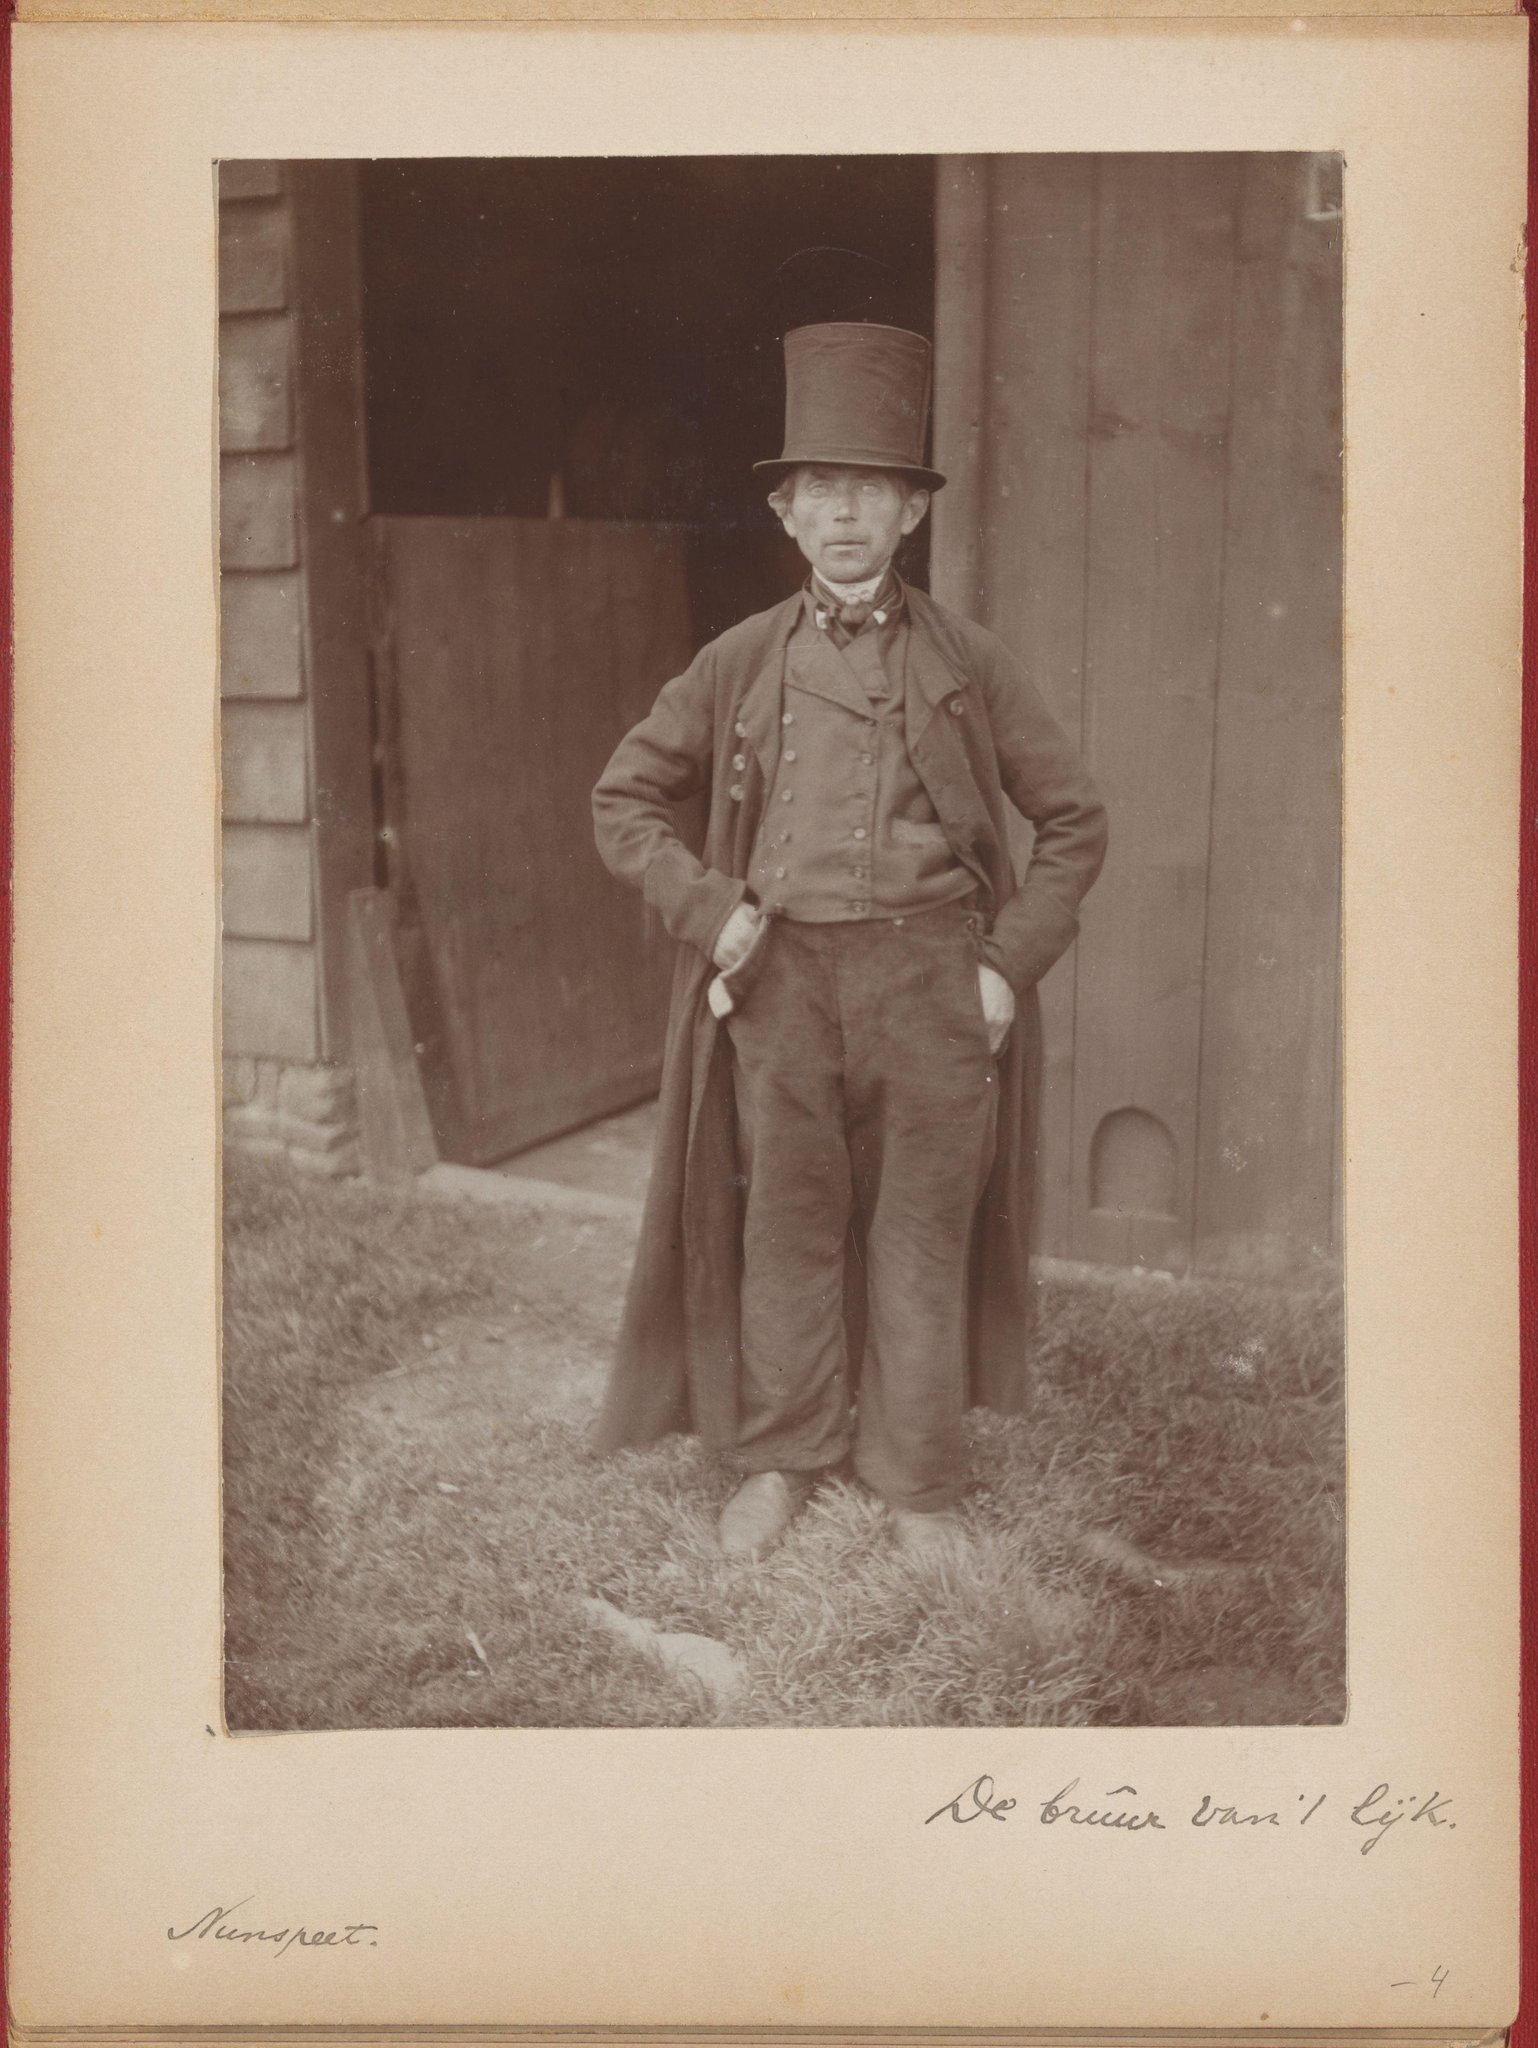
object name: photograph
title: 'De bruûr van 't lijk', man met hoge hoed in Nunspeet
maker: gerard aalbersberg (us)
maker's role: amateurfotograaf, arts, chirurg, gynaecoloog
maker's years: 1870-1934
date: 1809-1897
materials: paper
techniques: gelatin silver print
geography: nunspeet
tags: nunspeet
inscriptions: title: ‘De bruûr van 't lijk Nunspeet’